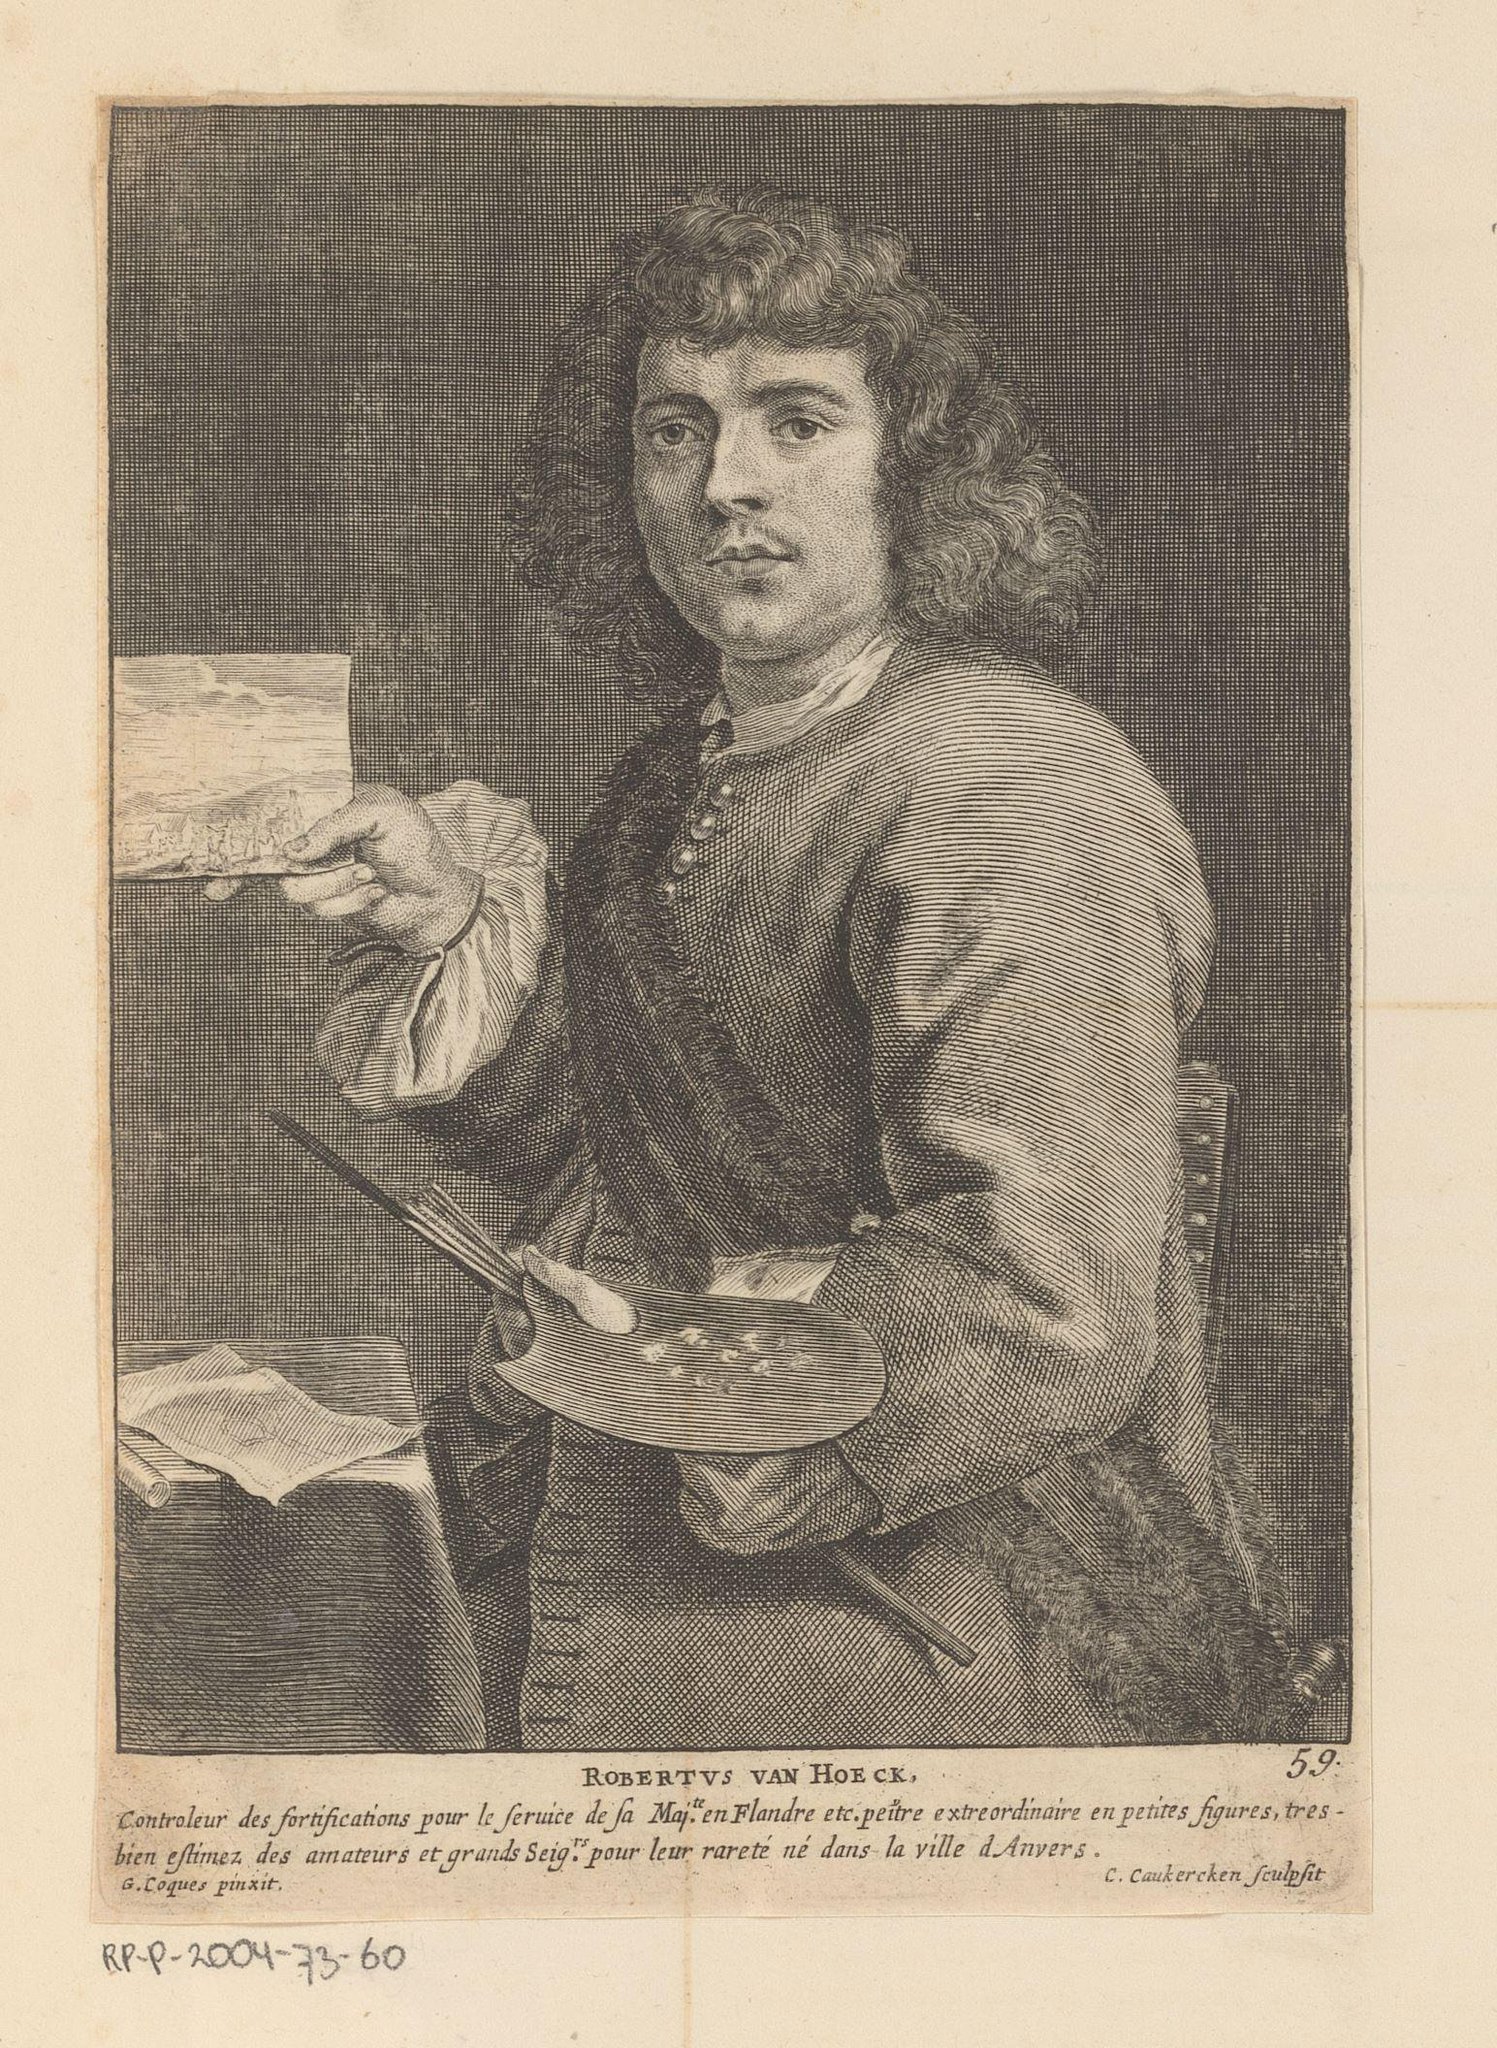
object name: book illustration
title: Portret van Robert van den Hoecke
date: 1649-1662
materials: paper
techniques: engraving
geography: antwerp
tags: painter, robert van den hoecke, historical persons, portrait, self-portrait of painter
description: Prent met tekst op verso gebruikt in: Bie, Cornelis De. Het gulden Cabinet vande edel vry schilder const, inhoudende den lof vande vermarste schilders, architecte, beldthowers ende plaetsnyders van dese eeuw. Antwerpen: Joannes Meyssens, 1662 [1661 foutief op titelpagina], p. 341. De samensteller heeft deze prent in het album geplakt als illustratie bij: Pilkington, Matthew en Johann Heinrich Füssli. A dictionary of painters, from the revival of the art to the present period. 4 dln. Londen: John Crowder, 1805, dl. 2, p. 236.